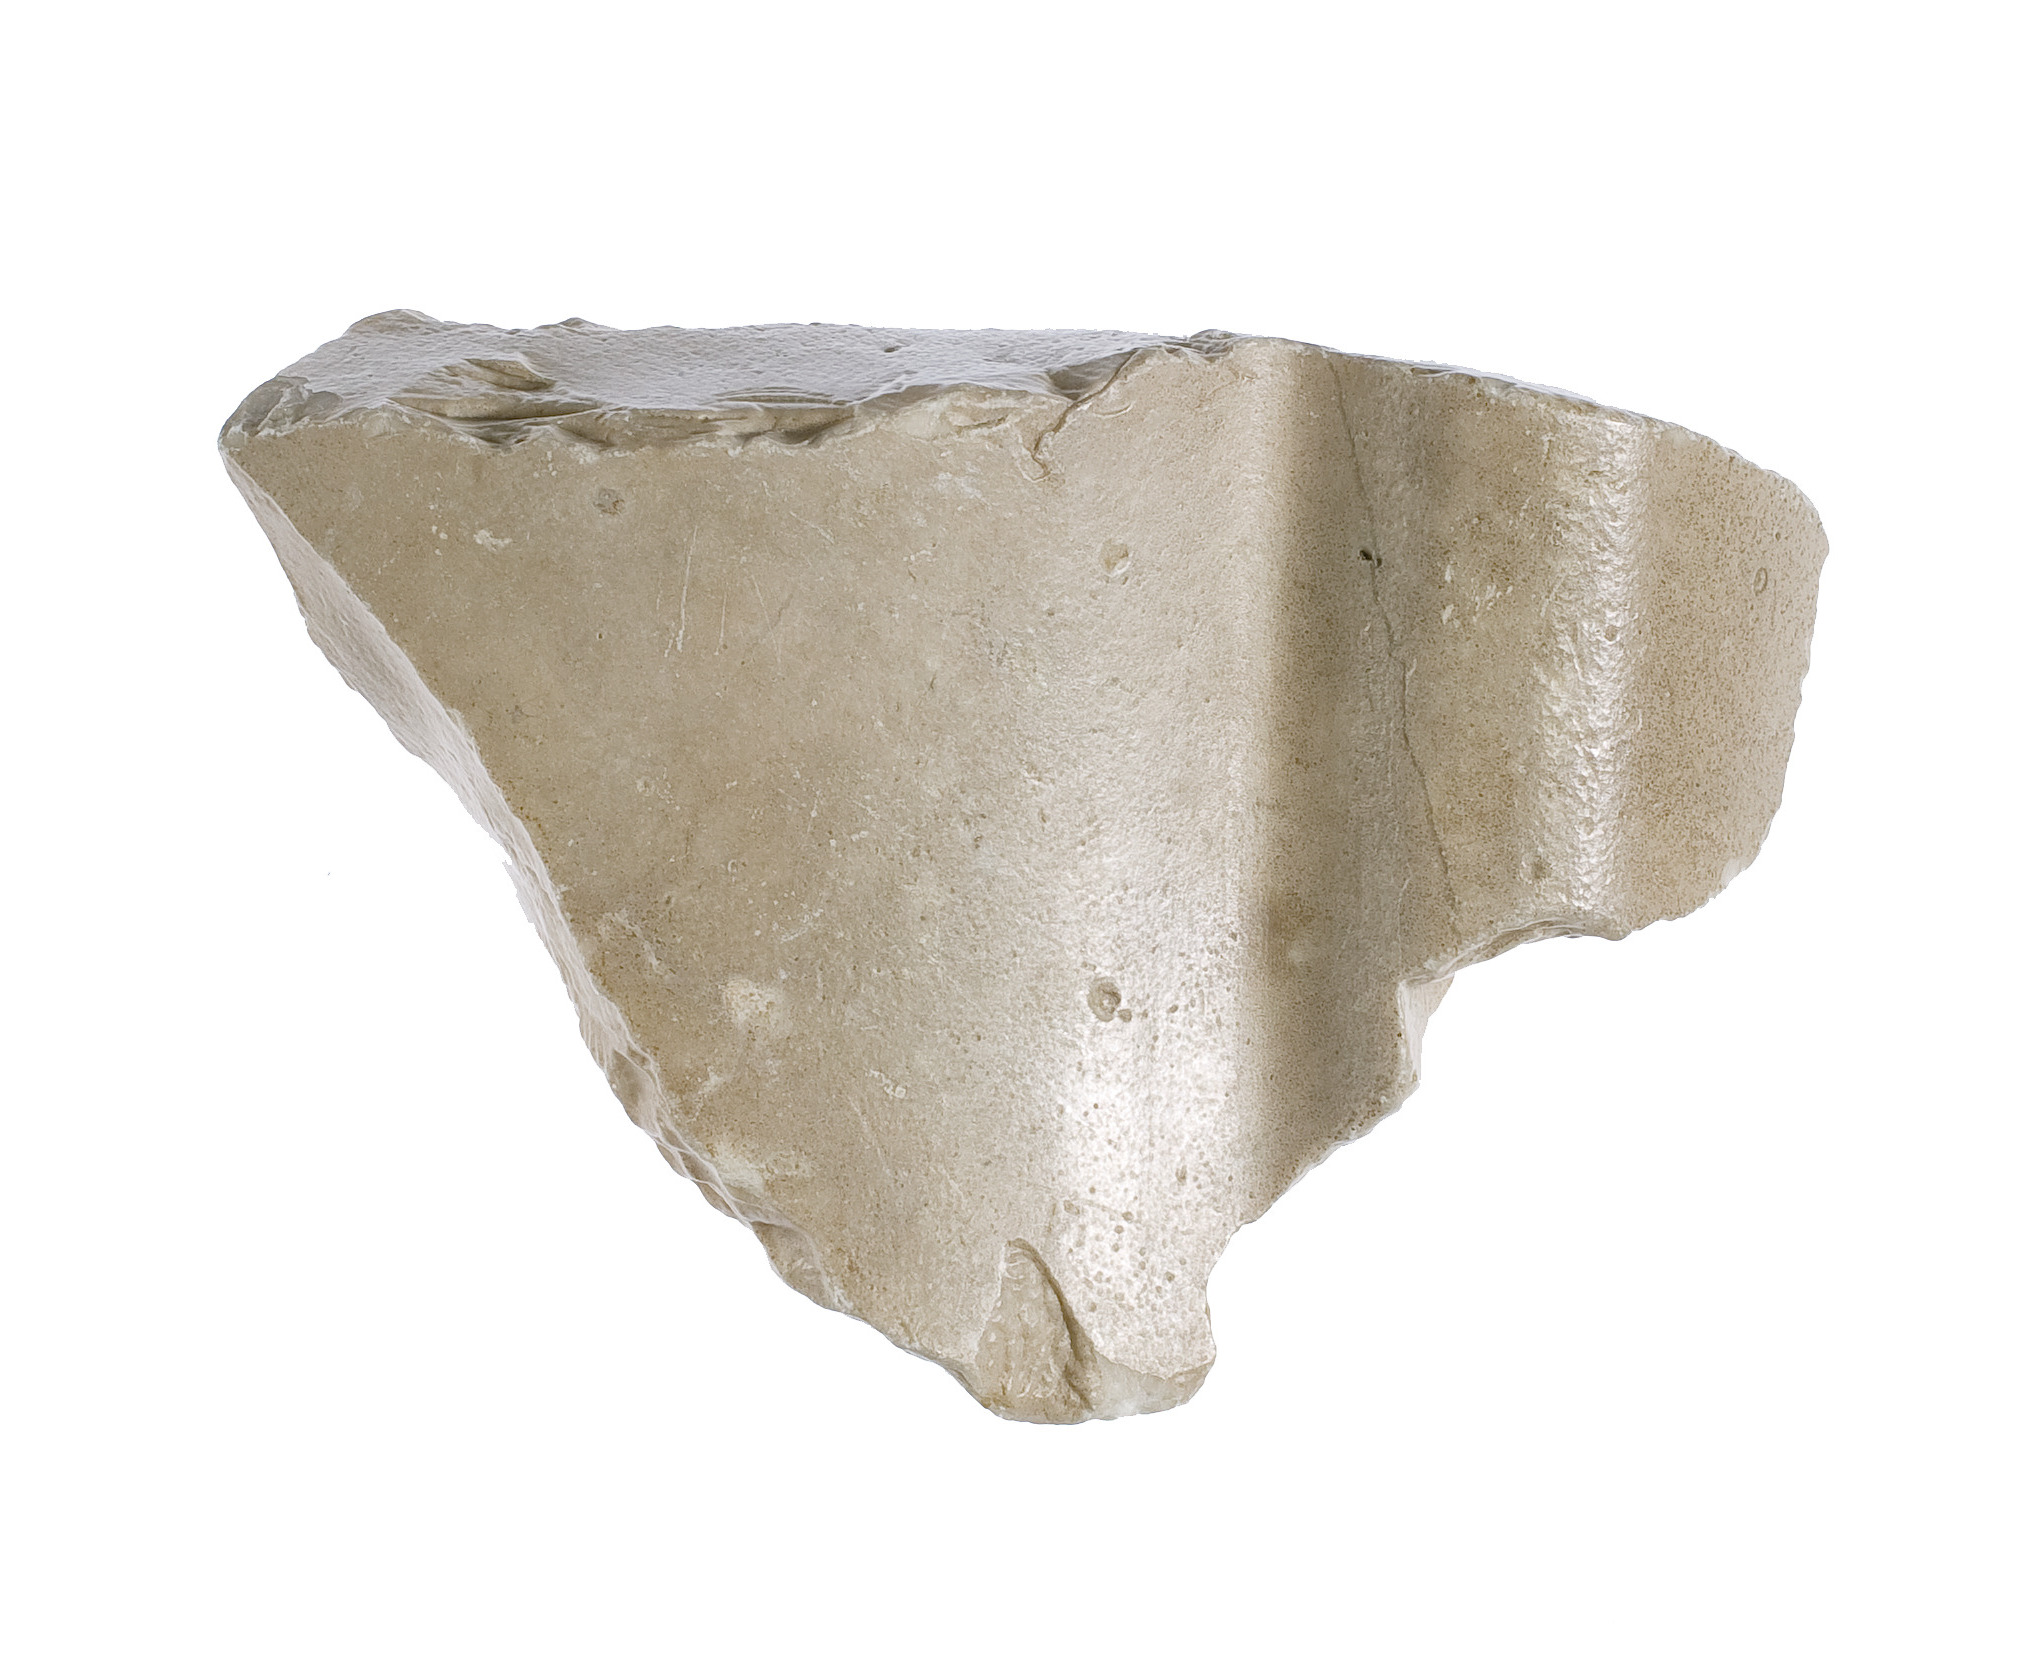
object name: unknown part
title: Limb with adjacent element (bull's tail?)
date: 1353-1336 BCE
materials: limestone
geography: egypt